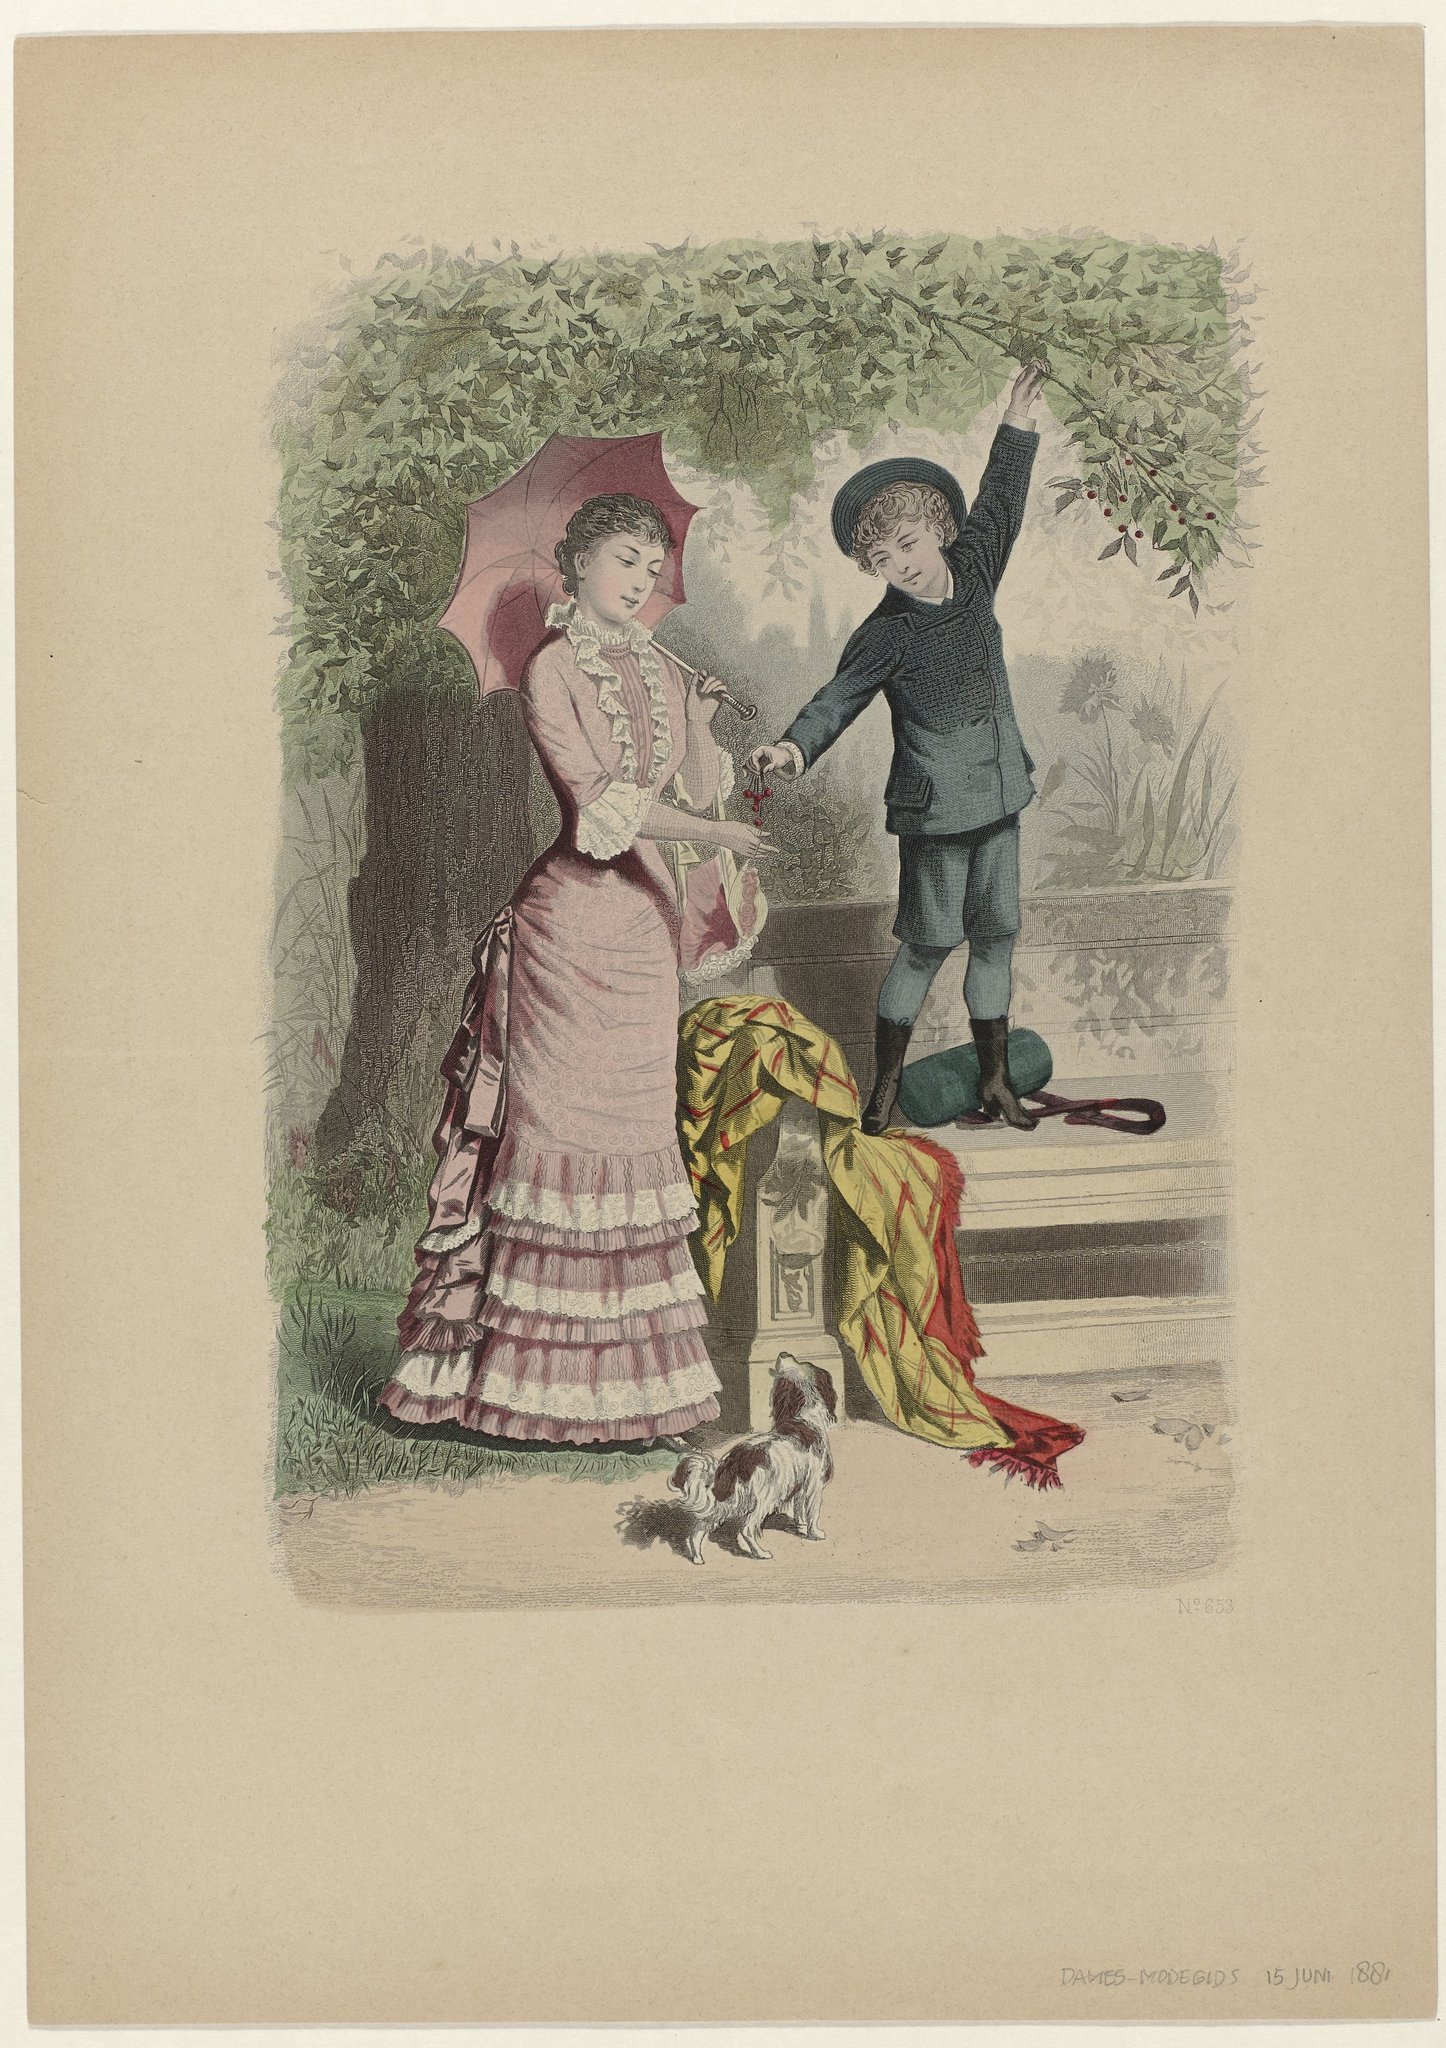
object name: fashion print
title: Dames-modegids, 15 juni 1881, No. 653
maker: Anonymous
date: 1881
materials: paper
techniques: engraving, hand coloring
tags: bench, clothing for the upper part of the body (shawl) (+ women's clothes), gloves, mittens (mitaines) (+ women's clothes), fashion plates, dress, gown (+ women's clothes), picking fruit, dog, parasol, sunshade (+ women's clothes)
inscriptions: inscription: ‘DAMES-MODEGIDS 15 JUNI 1881’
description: Een jongetje in een blauw pakje, plukt kersen uit de boom voor de jonge vrouw met parasol. Op de bank ligt een grote shawl. Prent uit het modetijdschrift Dames-modegids (1873-...).